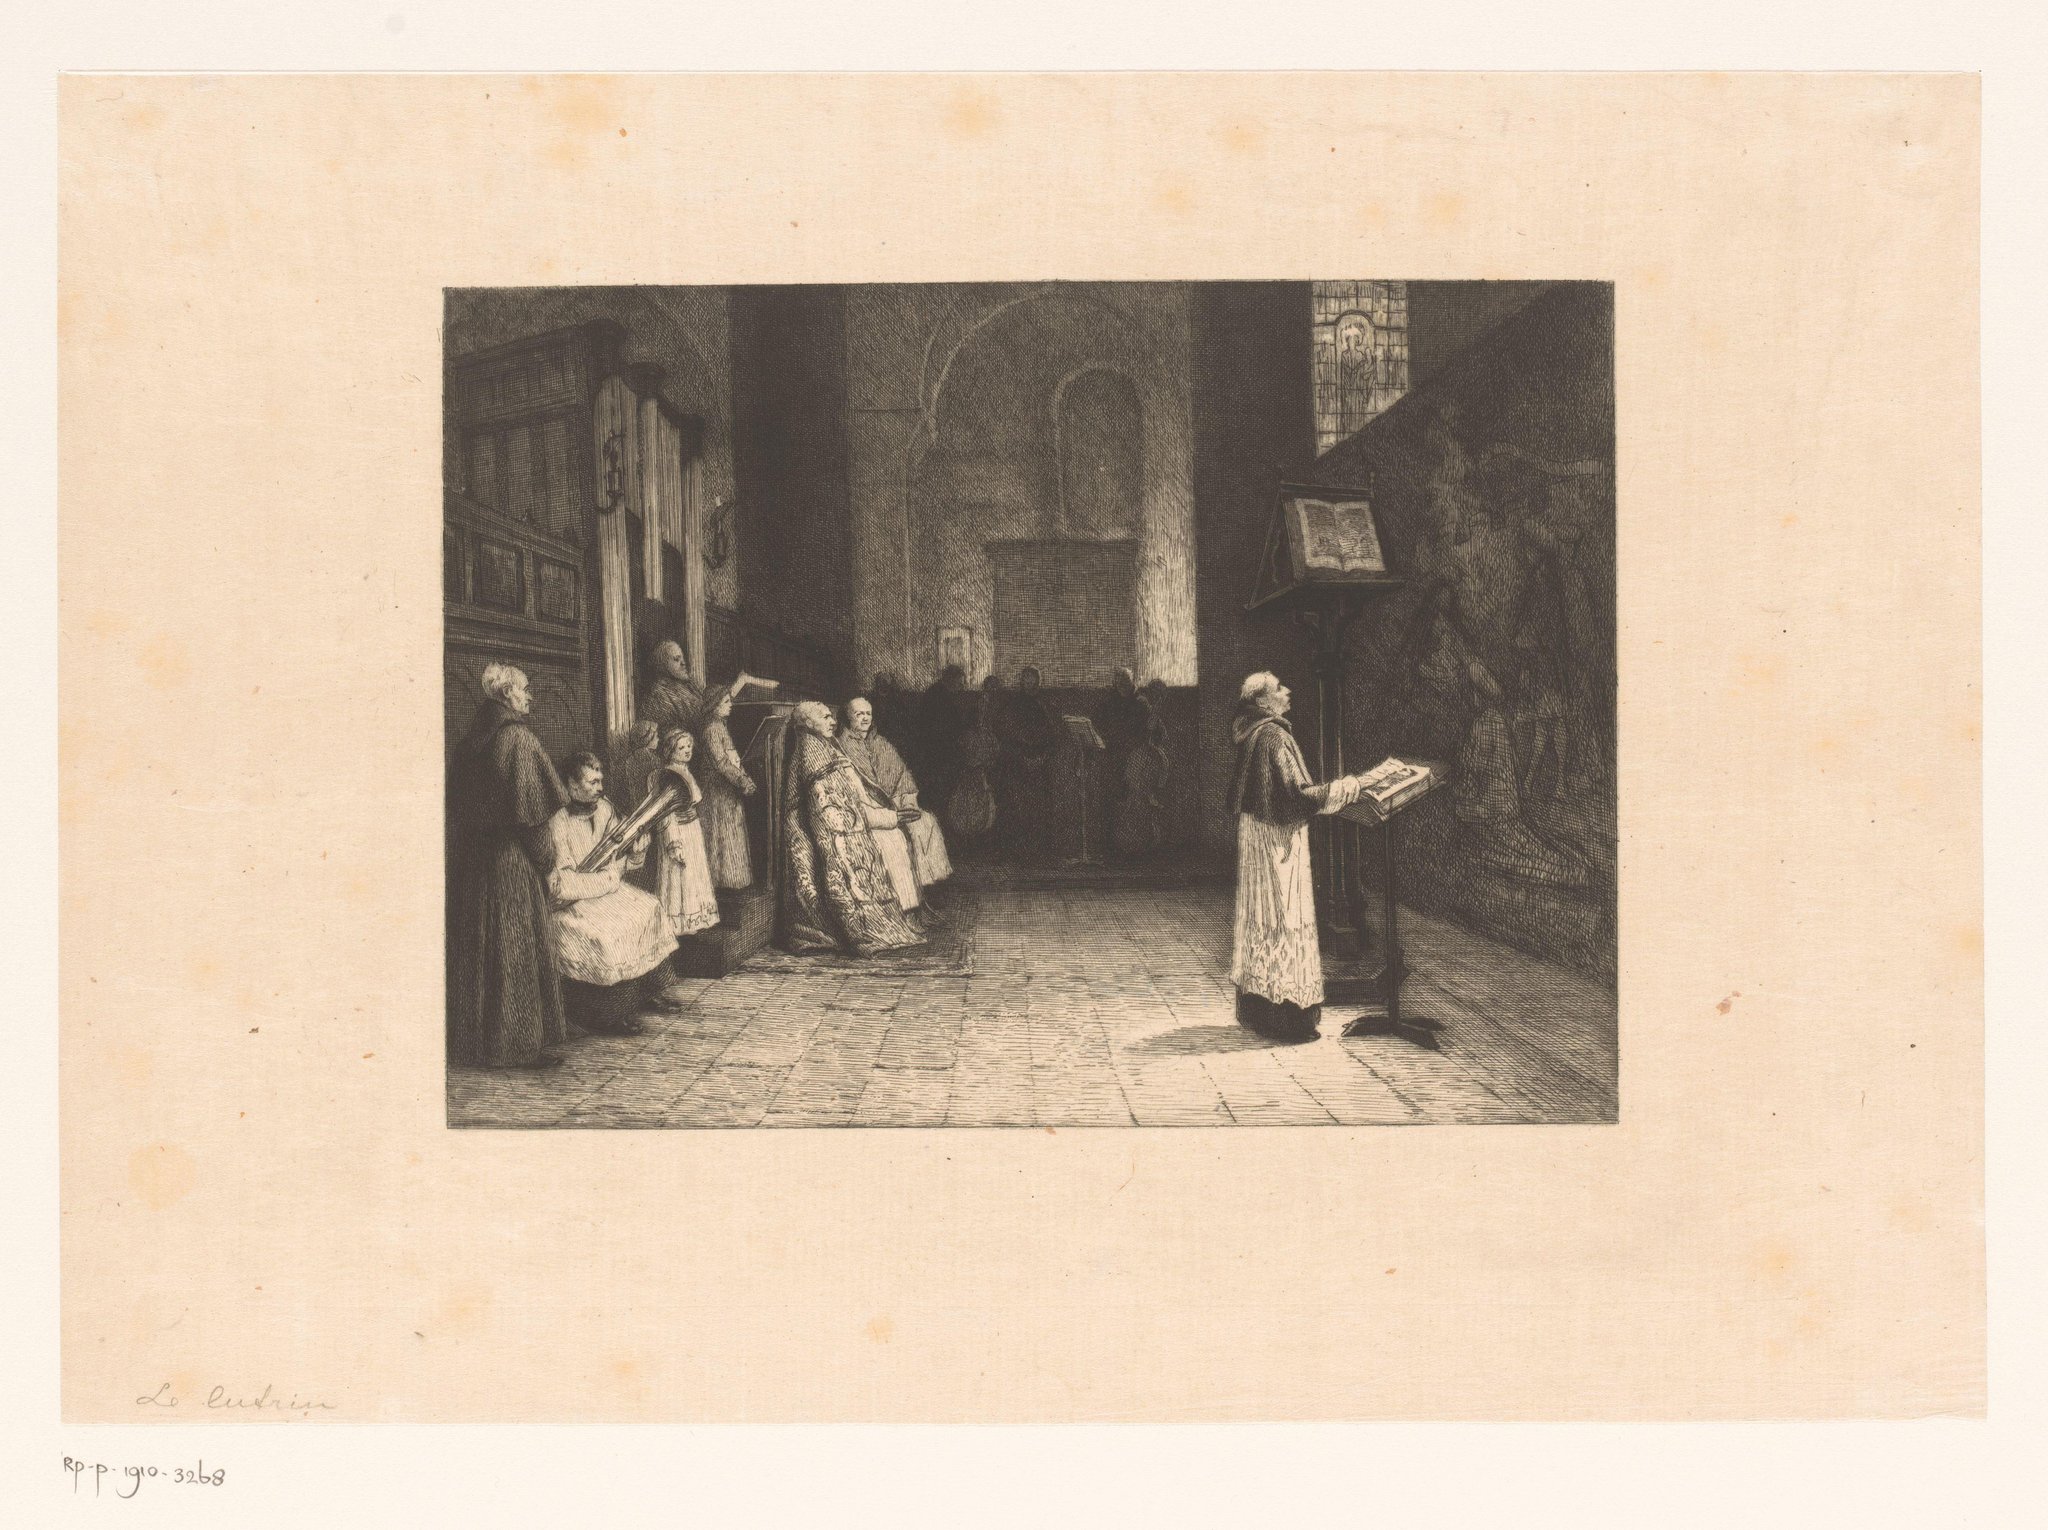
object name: print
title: Le lutrin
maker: léopold flameng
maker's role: print maker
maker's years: 1831-1911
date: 1841-1887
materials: paper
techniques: etching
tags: divine service ~ christian churches, interior of church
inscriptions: collector's mark: Lugt 2228